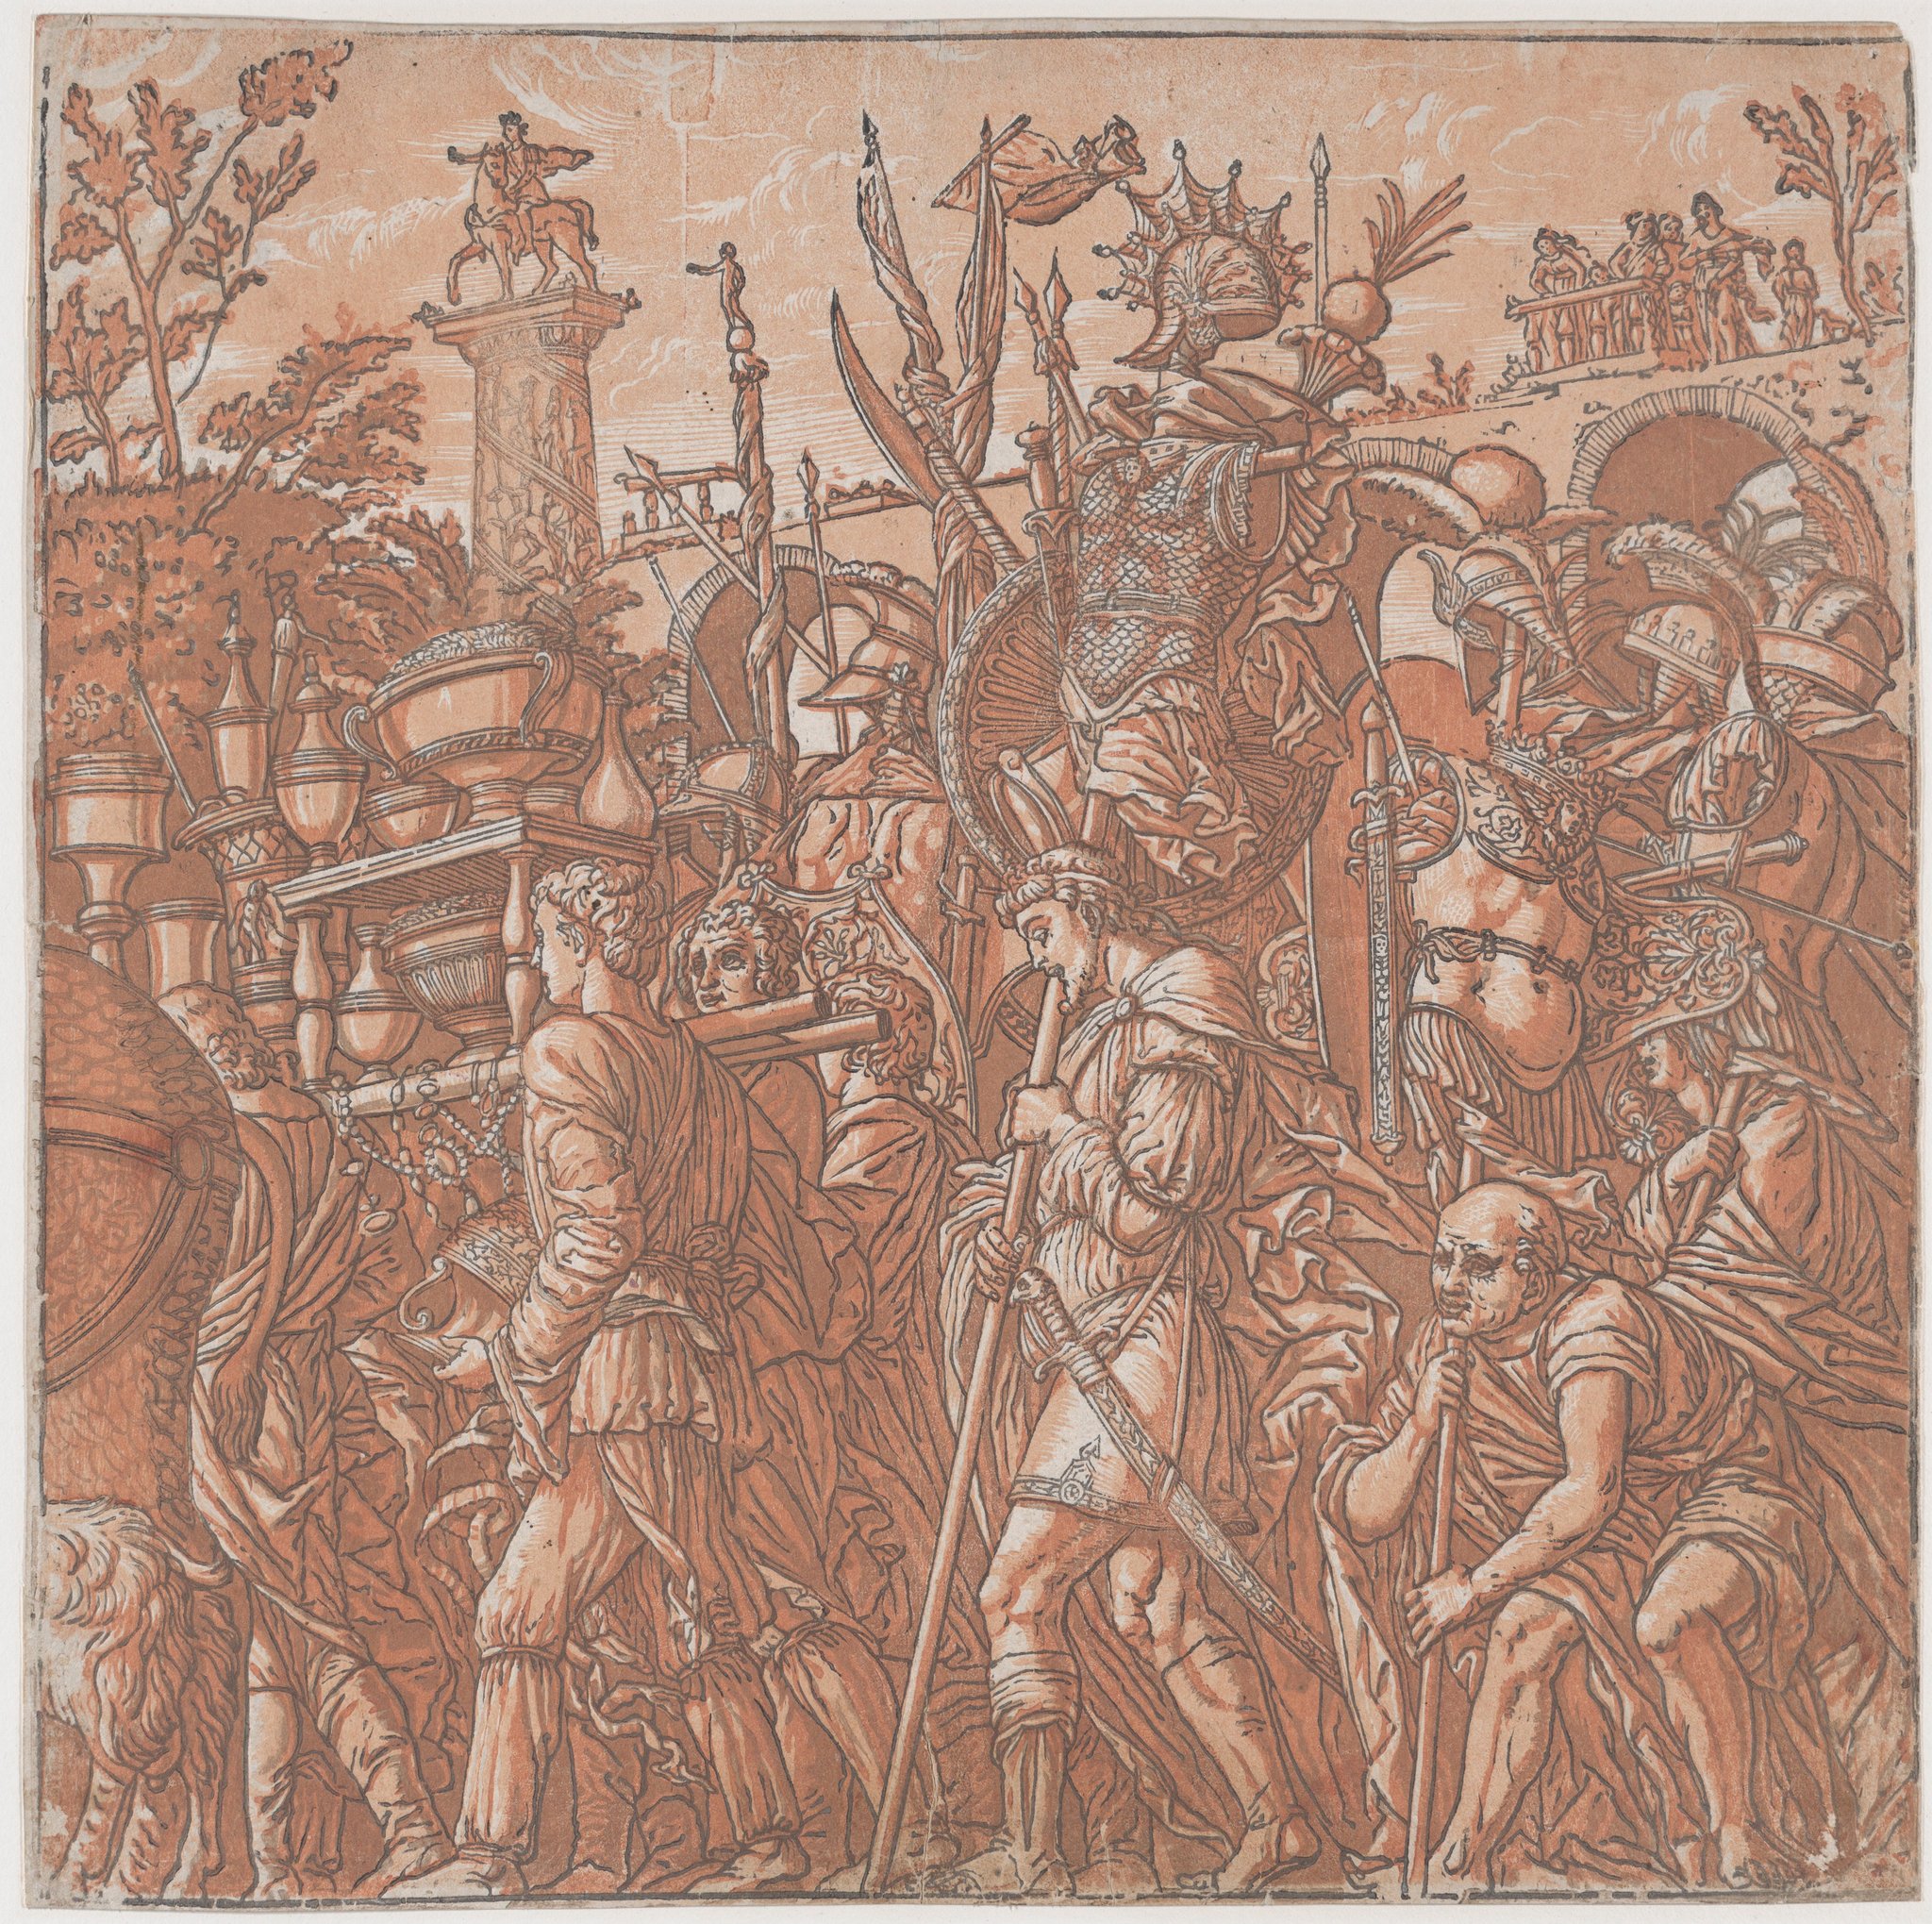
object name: print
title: Sheet 6: Men carrying trophies, from "The Triumph of Julius Caesar"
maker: andrea andreani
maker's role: artist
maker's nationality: italian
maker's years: 1558-1629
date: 1599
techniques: woodcut, printing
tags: armor,men